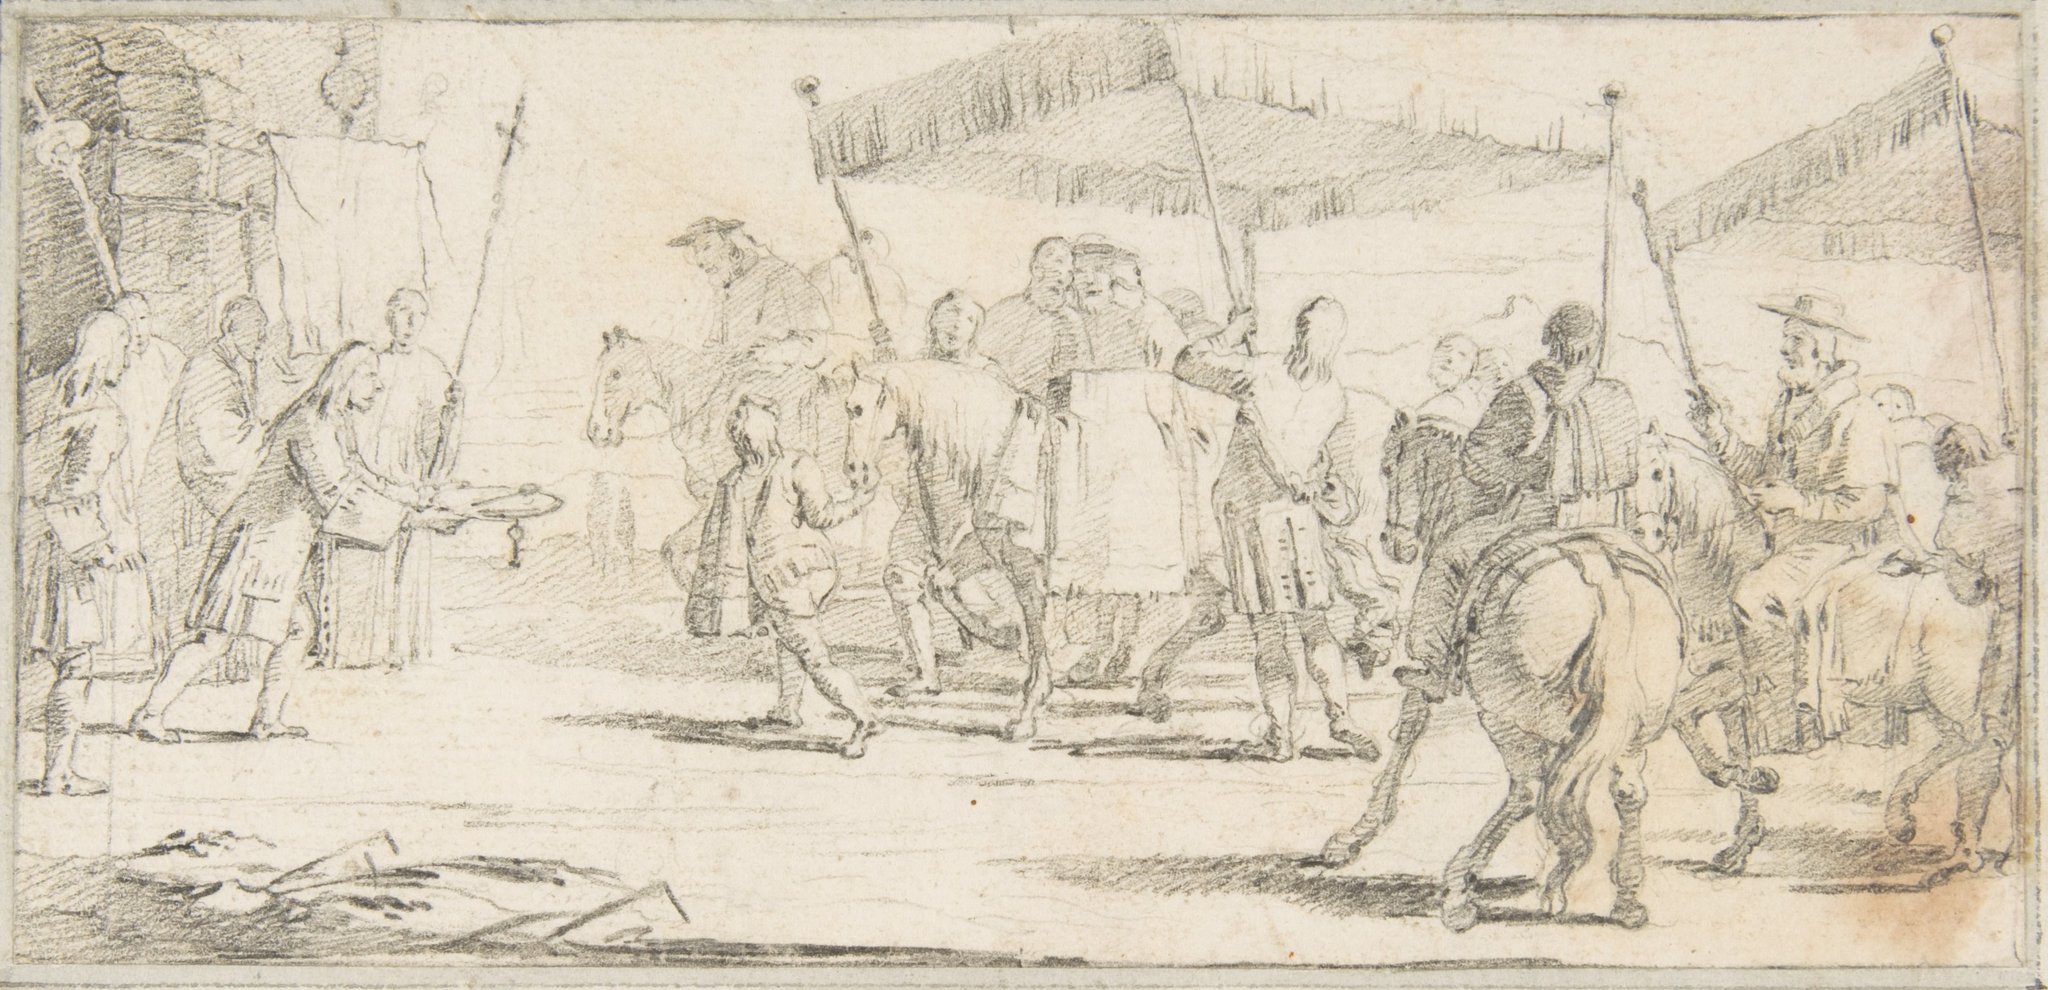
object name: drawing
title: Illustration for a Book: Keys of a City Offered to a Procession of Cardinals Headed by a Riderless Horse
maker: giovanni battista tiepolo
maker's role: artist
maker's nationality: italian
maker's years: 1696-1770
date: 1696-1770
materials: chalk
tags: human figures,horses